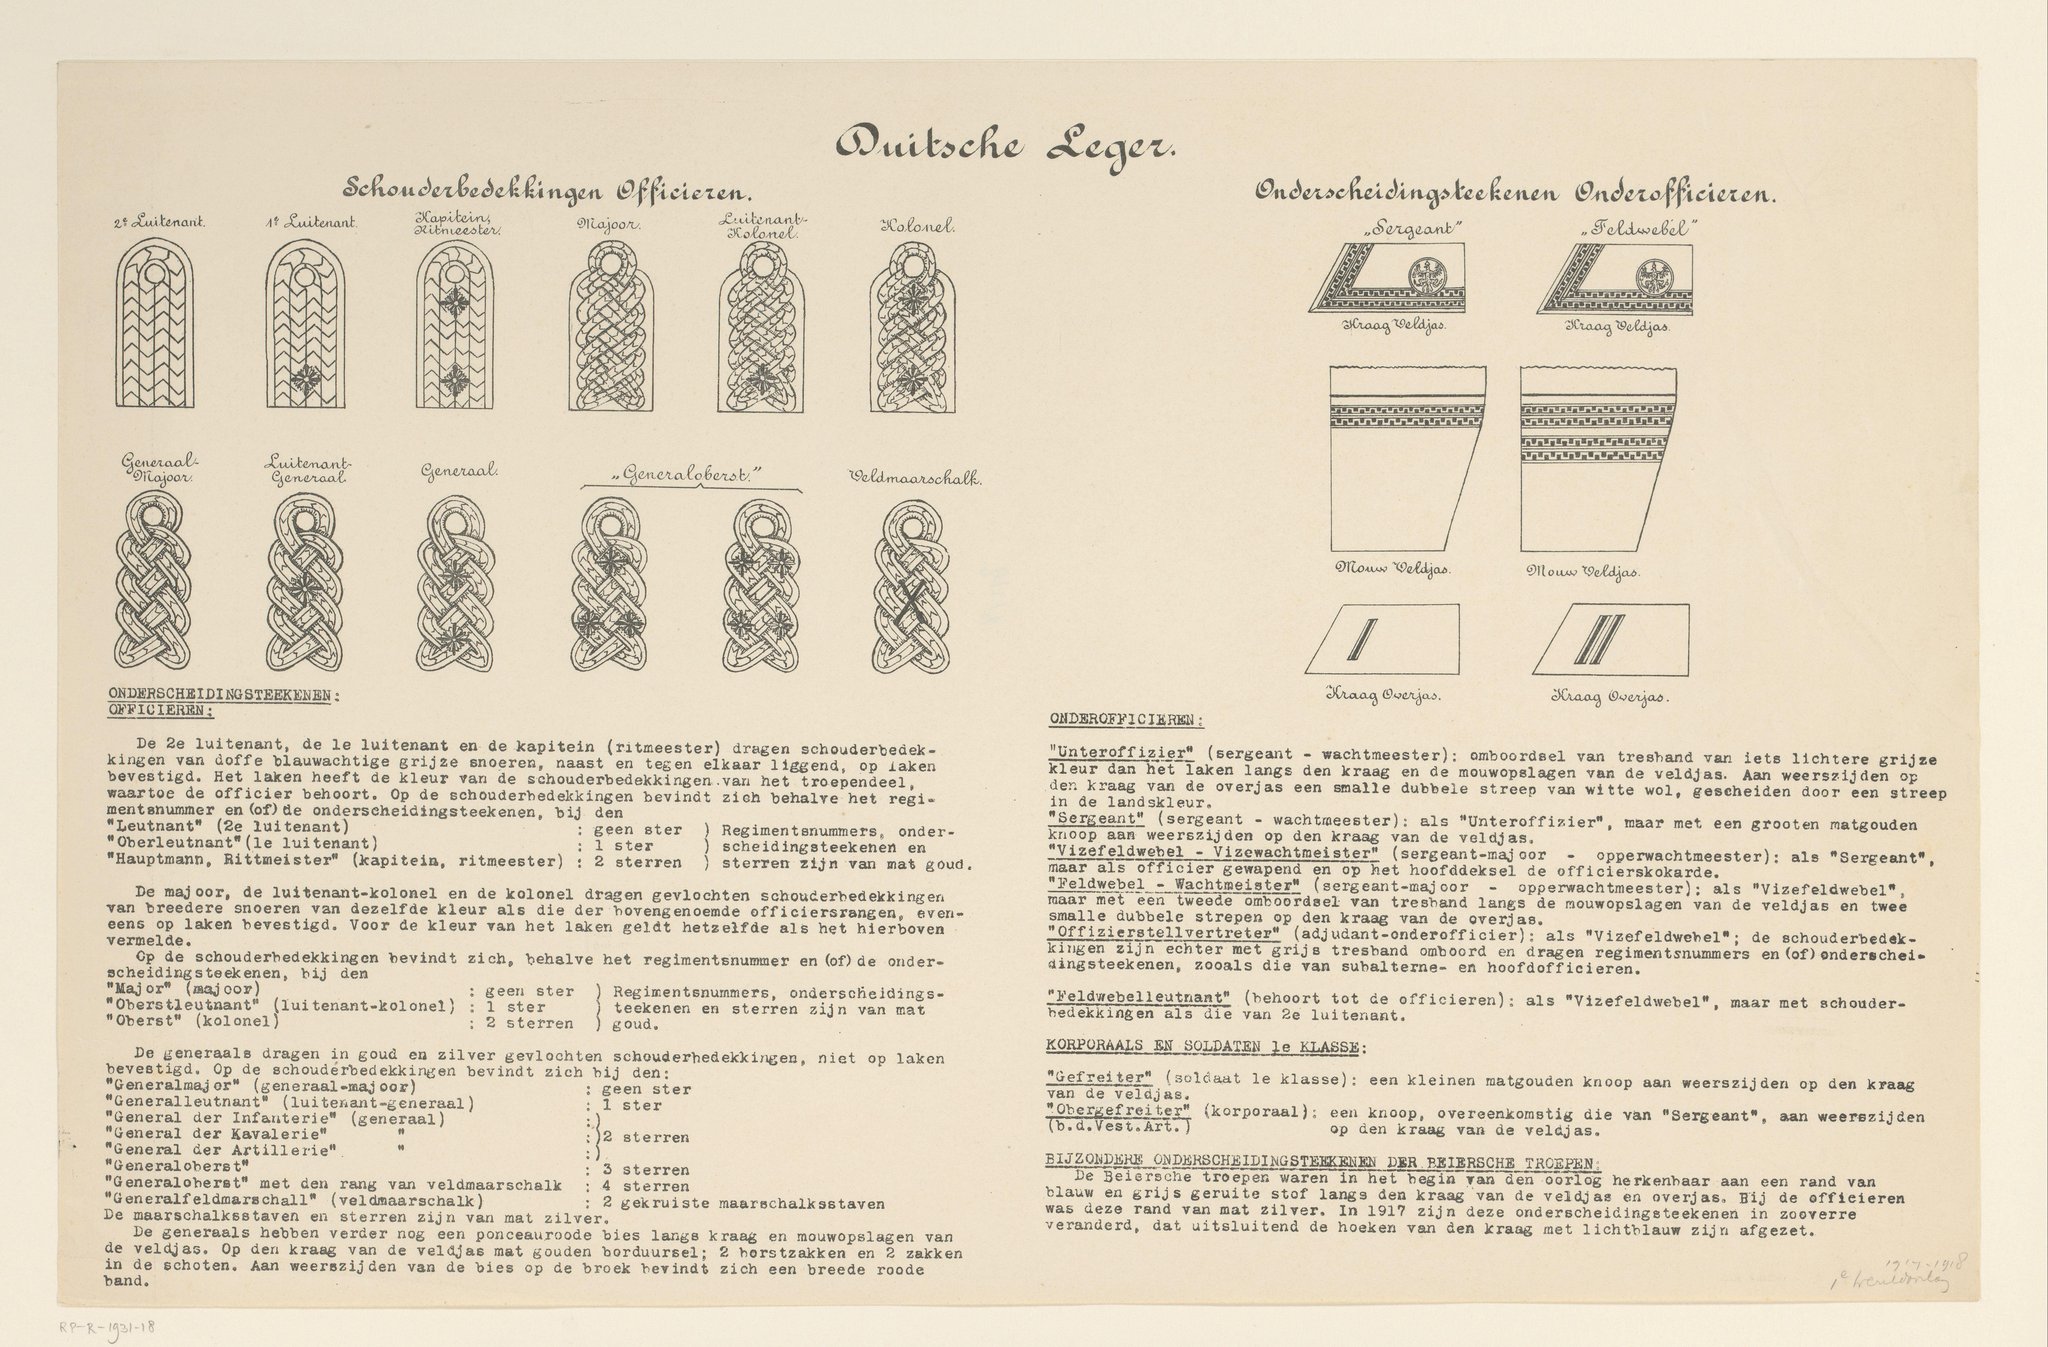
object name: print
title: Duitsche Leger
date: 1914-1918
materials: paper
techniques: autotype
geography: netherlands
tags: (military) uniforms, germany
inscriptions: collector's mark: Lugt 2228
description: Overzicht van de onderscheidingstekenen op de uniformen van het Duitse leger tijdens de Eerste Wereldoorlog.